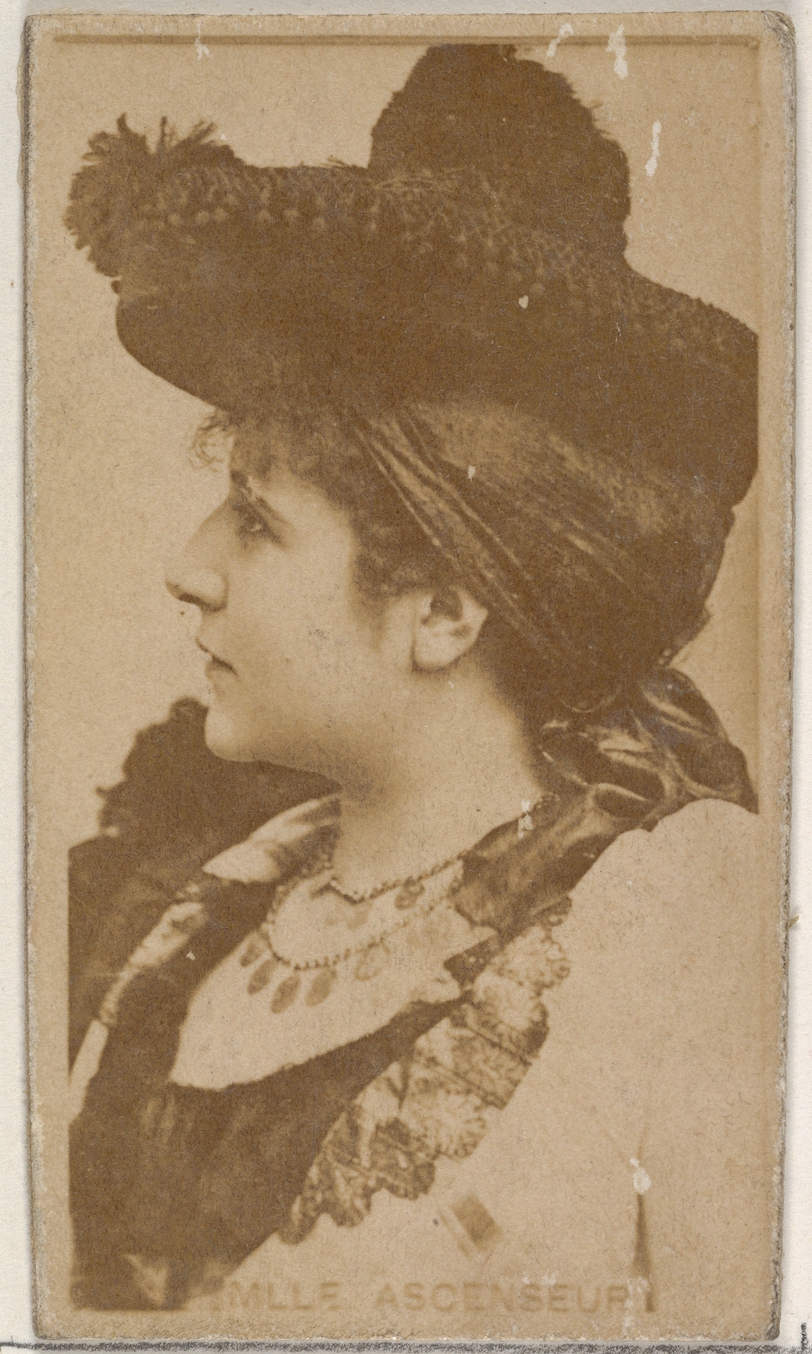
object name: photograph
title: Mlle. Ascenseur, from the Actors and Actresses series (N45, Type 8) for Virginia Brights Cigarettes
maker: allen & ginter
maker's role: publisher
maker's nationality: american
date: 1888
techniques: albumen silver print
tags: portraits,profiles,women,actresses